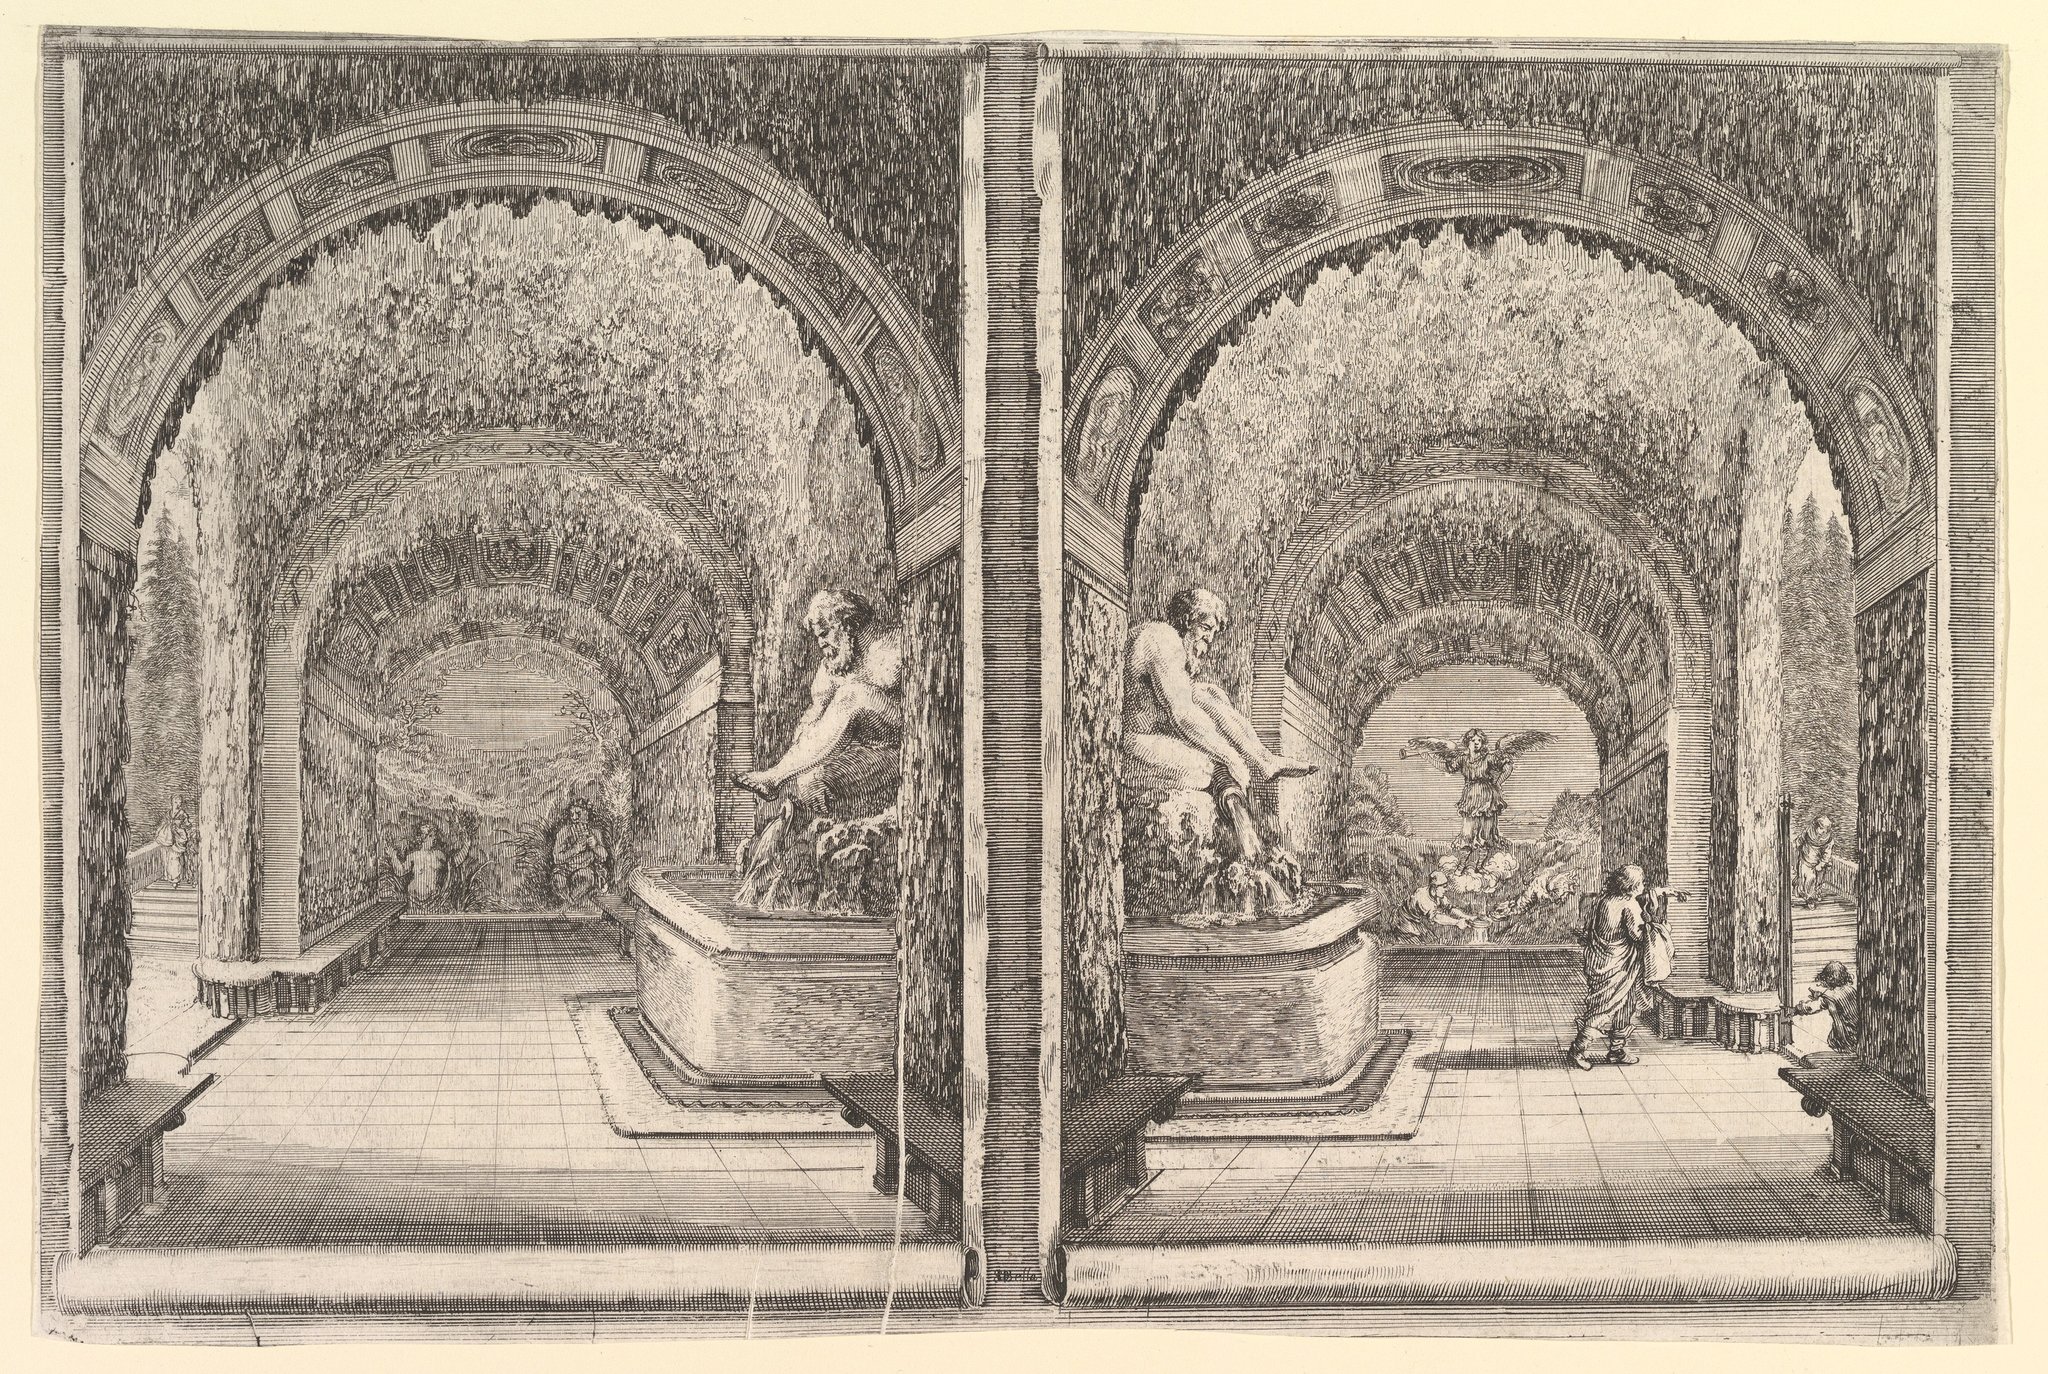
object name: print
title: Two views of a grotto, from "Views of the villa at Pratolino" (Vues de la villa de Pratolino)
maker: stefano della bella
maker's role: artist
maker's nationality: italian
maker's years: 1610-1664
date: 1653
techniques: etching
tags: sculpture,fountains